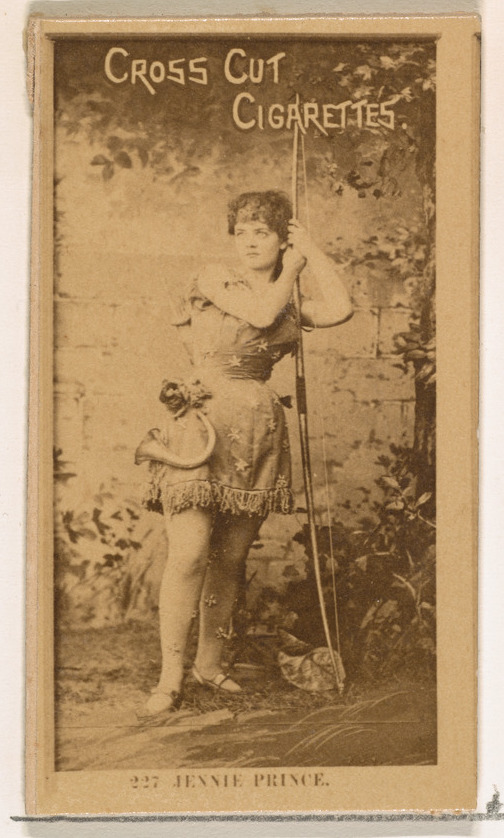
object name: print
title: Card Number 227, Jennie Prince, from the Actors and Actresses series (N145-2) issued by Duke Sons & Co. to promote Cross Cut Cigarettes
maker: w. duke, sons & co.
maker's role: publisher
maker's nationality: american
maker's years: 1870-1920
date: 1880-1889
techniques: albumen silver print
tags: portraits,women,actresses